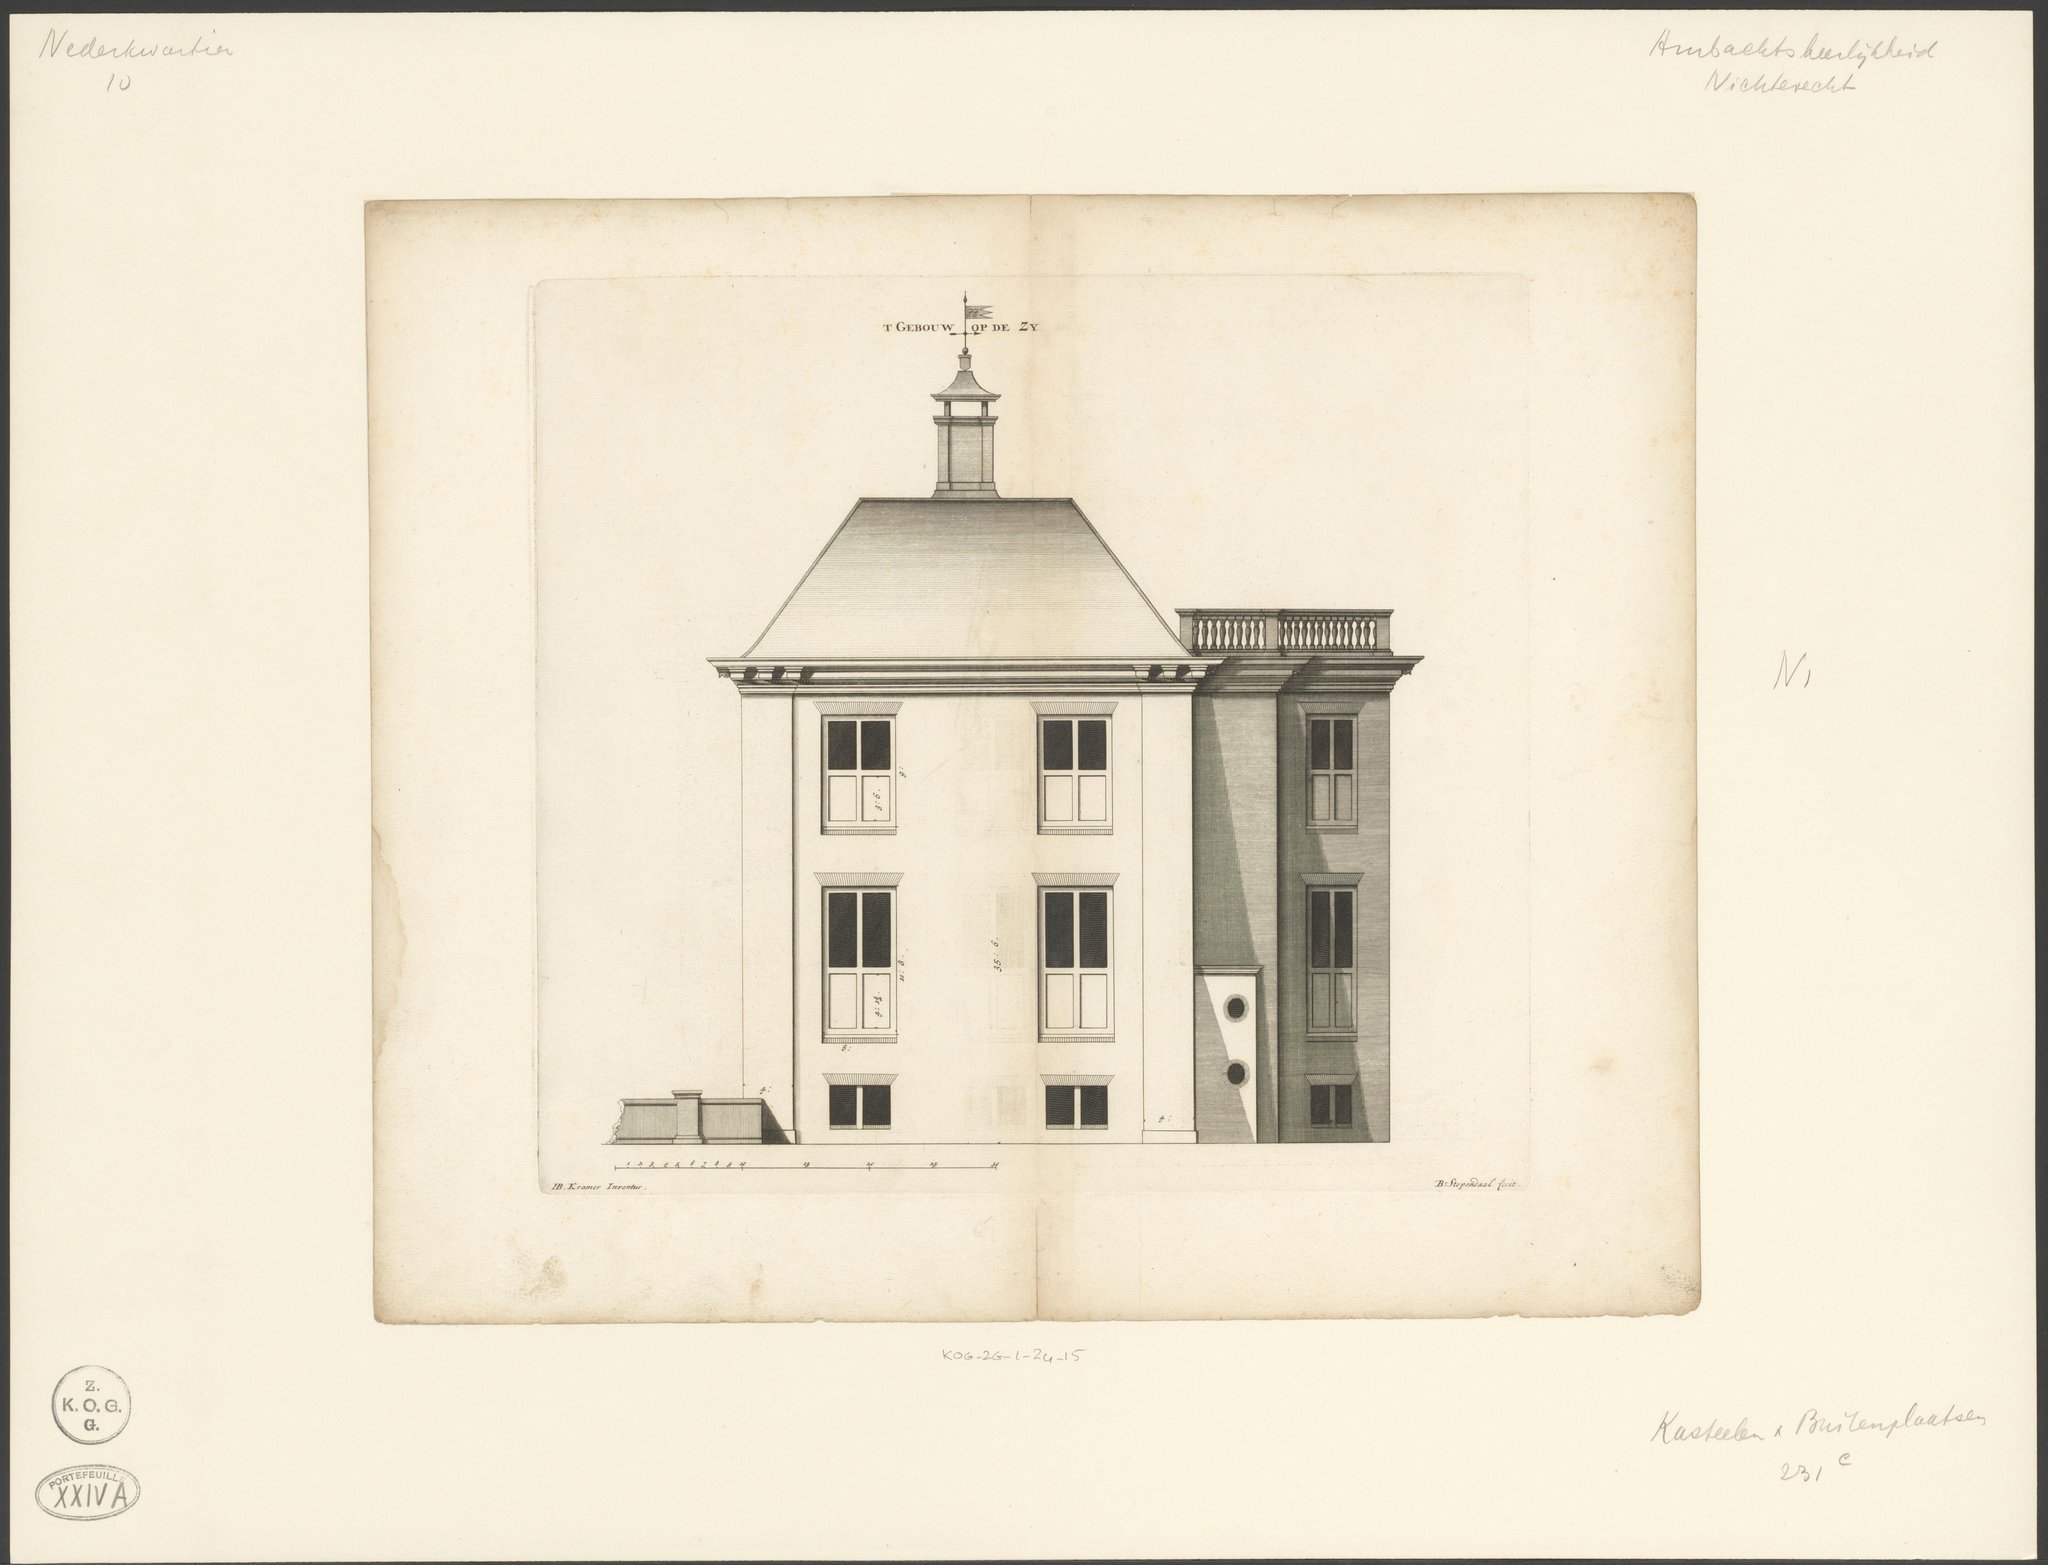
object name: print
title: Zijaanzicht van buitenhuis De Nes te Vreeland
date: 1687-1693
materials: paper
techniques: engraving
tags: exterior ~ representation of a building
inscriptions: collector's mark: Lugt 1641, stamp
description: Zijaanzicht van huis De Nes of Realeneiland te Vreeland. Het voor de Amsterdamse familie Reaal in 1687 gebouwde buitenhuis lag op een eiland in de Vecht. Onderwerpsrubrieken binnen de Atlas Zeden en Gewoonten: Zeden en Gewoonten in Engeren Zin, De Woning. Kastelen en buitenplaatsen. Utrecht (vervolg.).